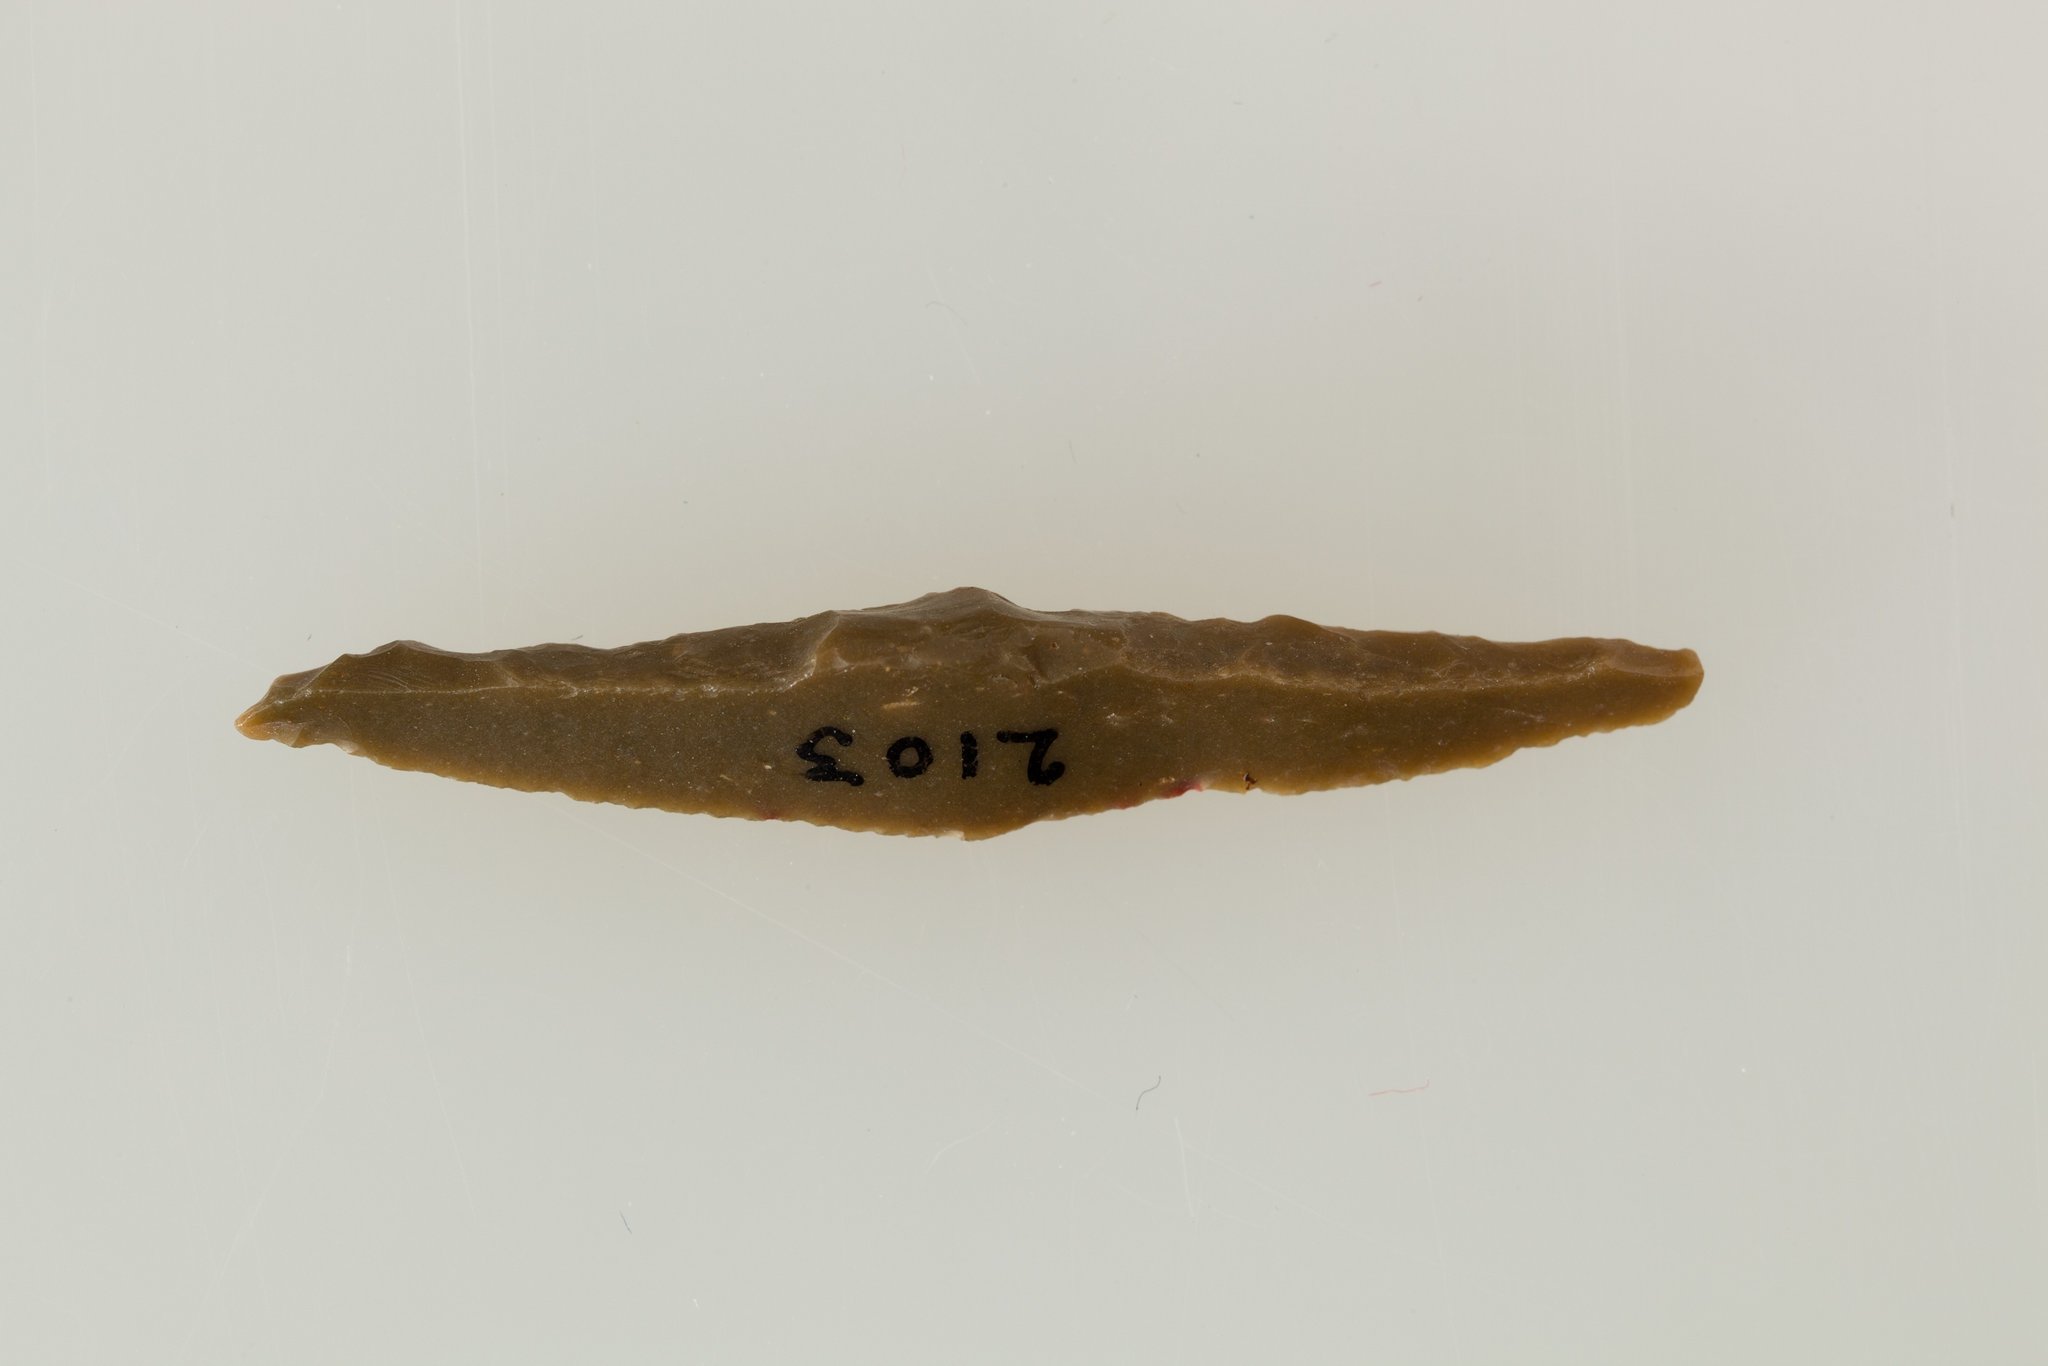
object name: tool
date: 3850-2960 BCE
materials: stone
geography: egypt